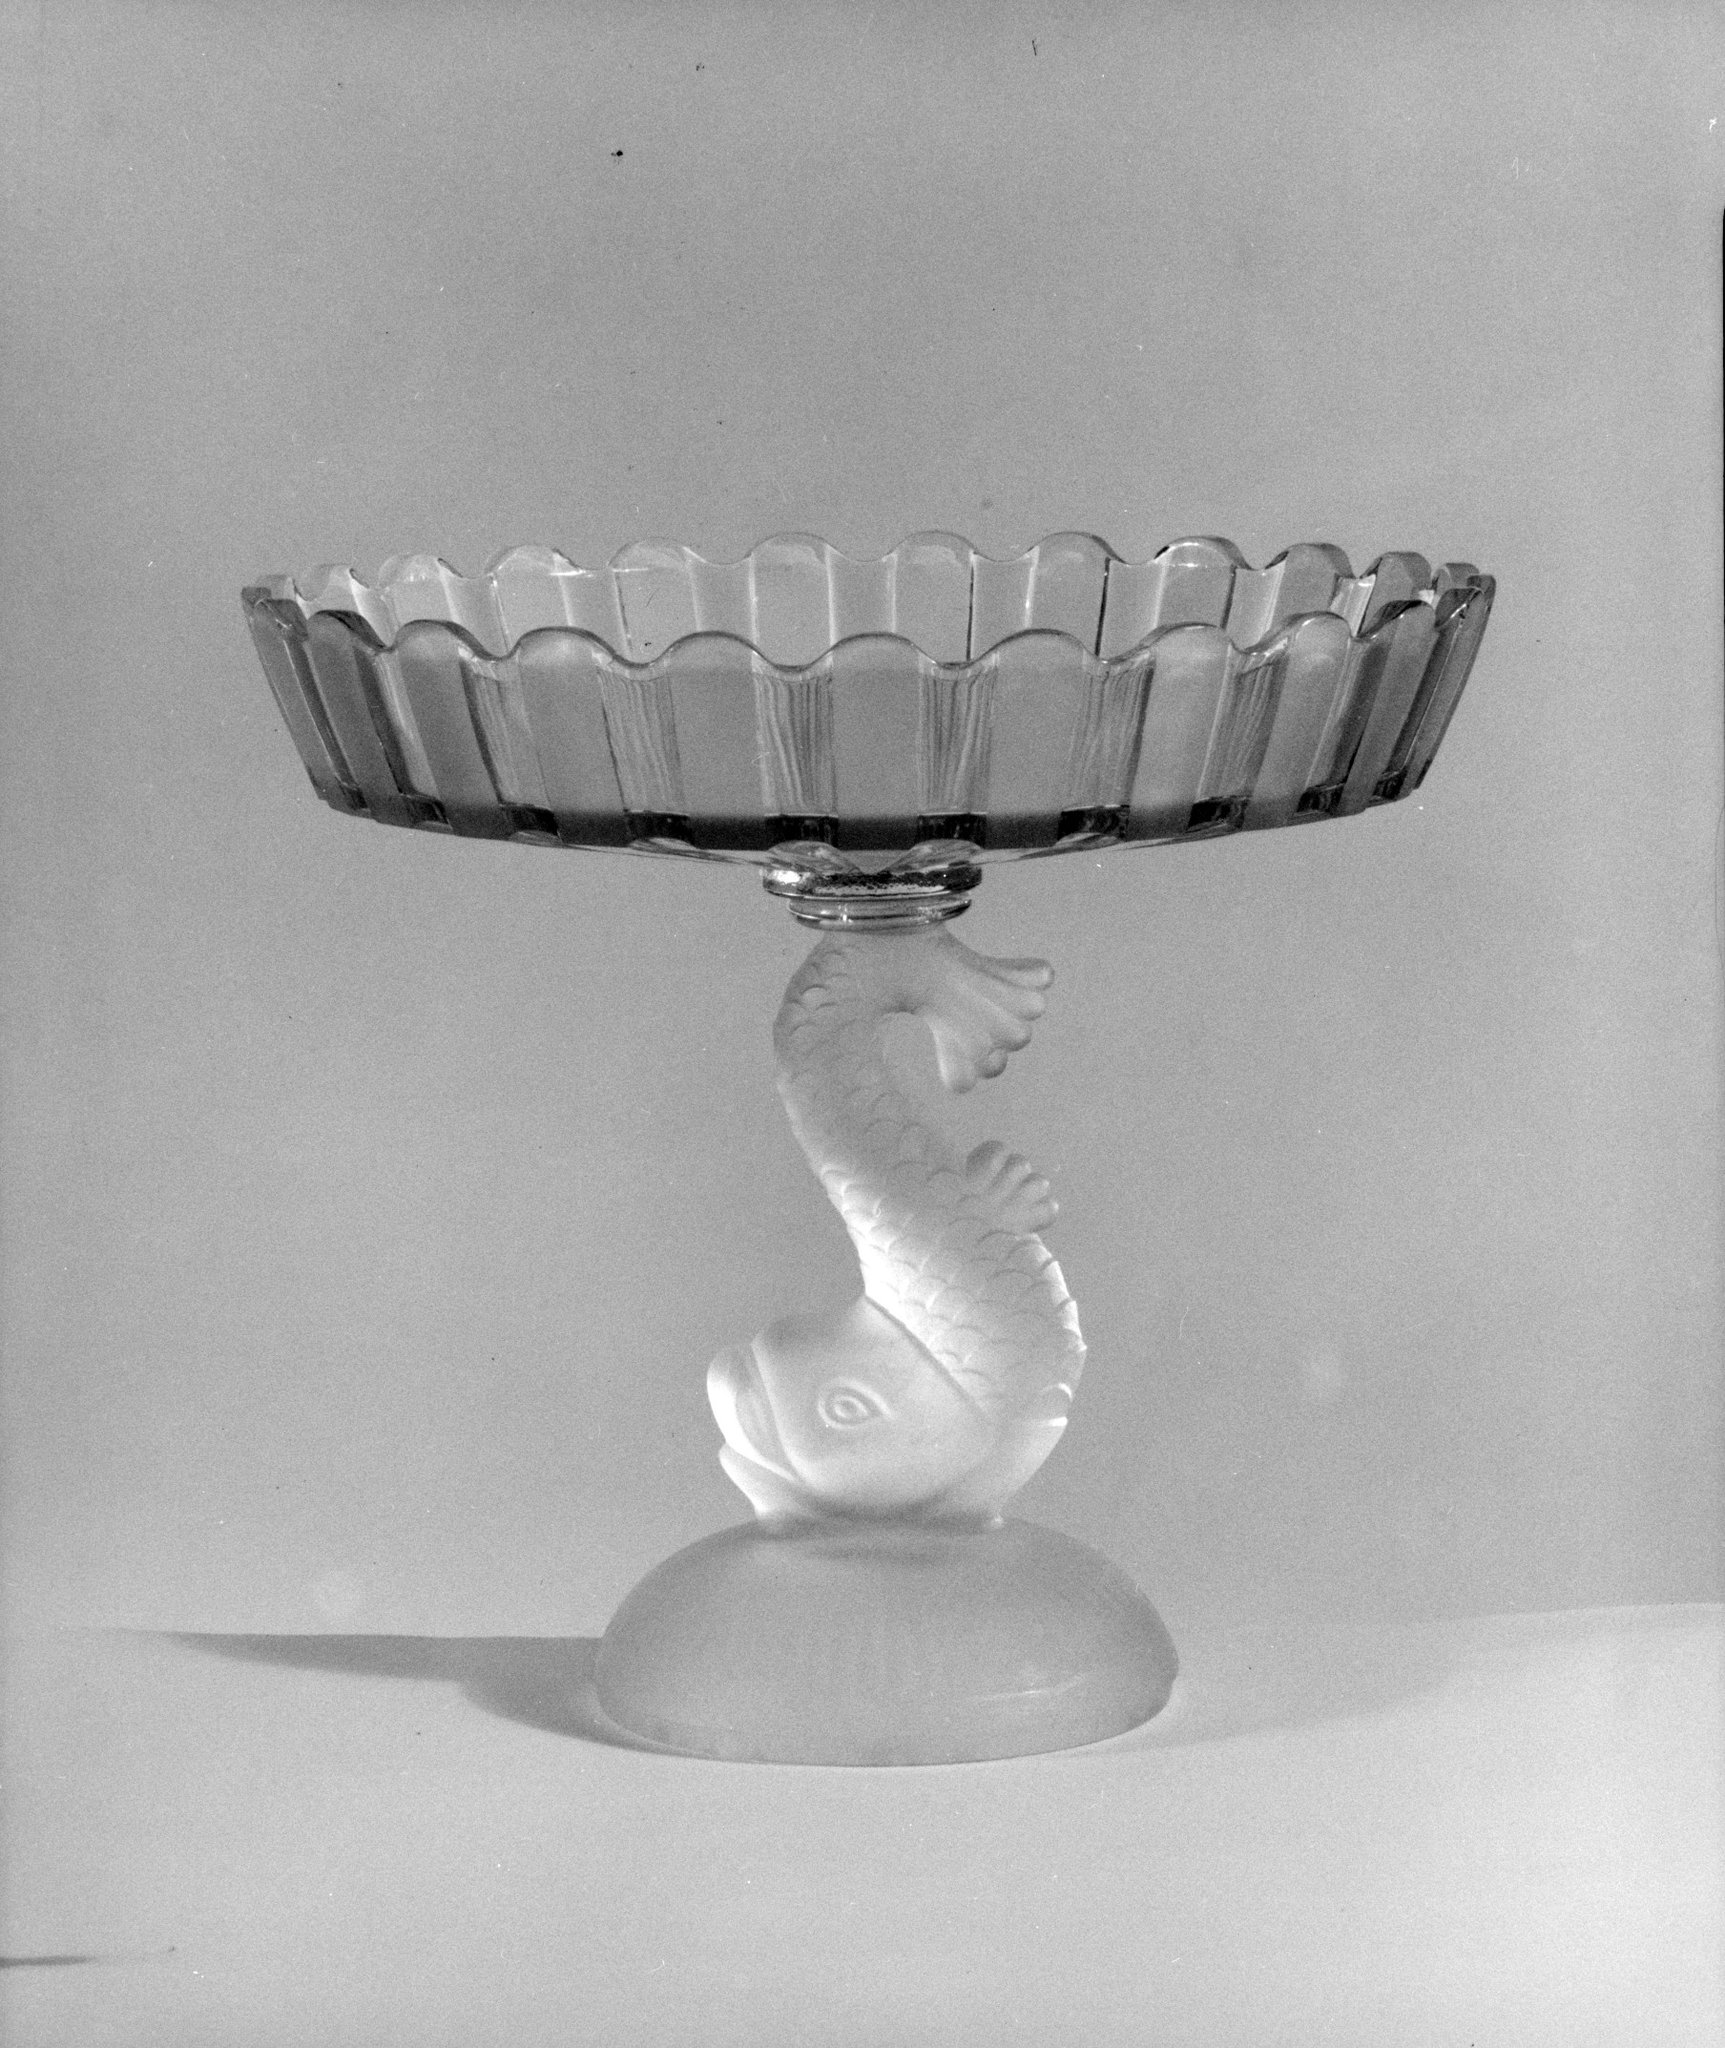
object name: compote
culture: american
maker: bakewell, pears and company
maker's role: maker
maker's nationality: american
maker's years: 1836-1882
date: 1860-1880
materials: glass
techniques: pressed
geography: united states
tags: dolphins